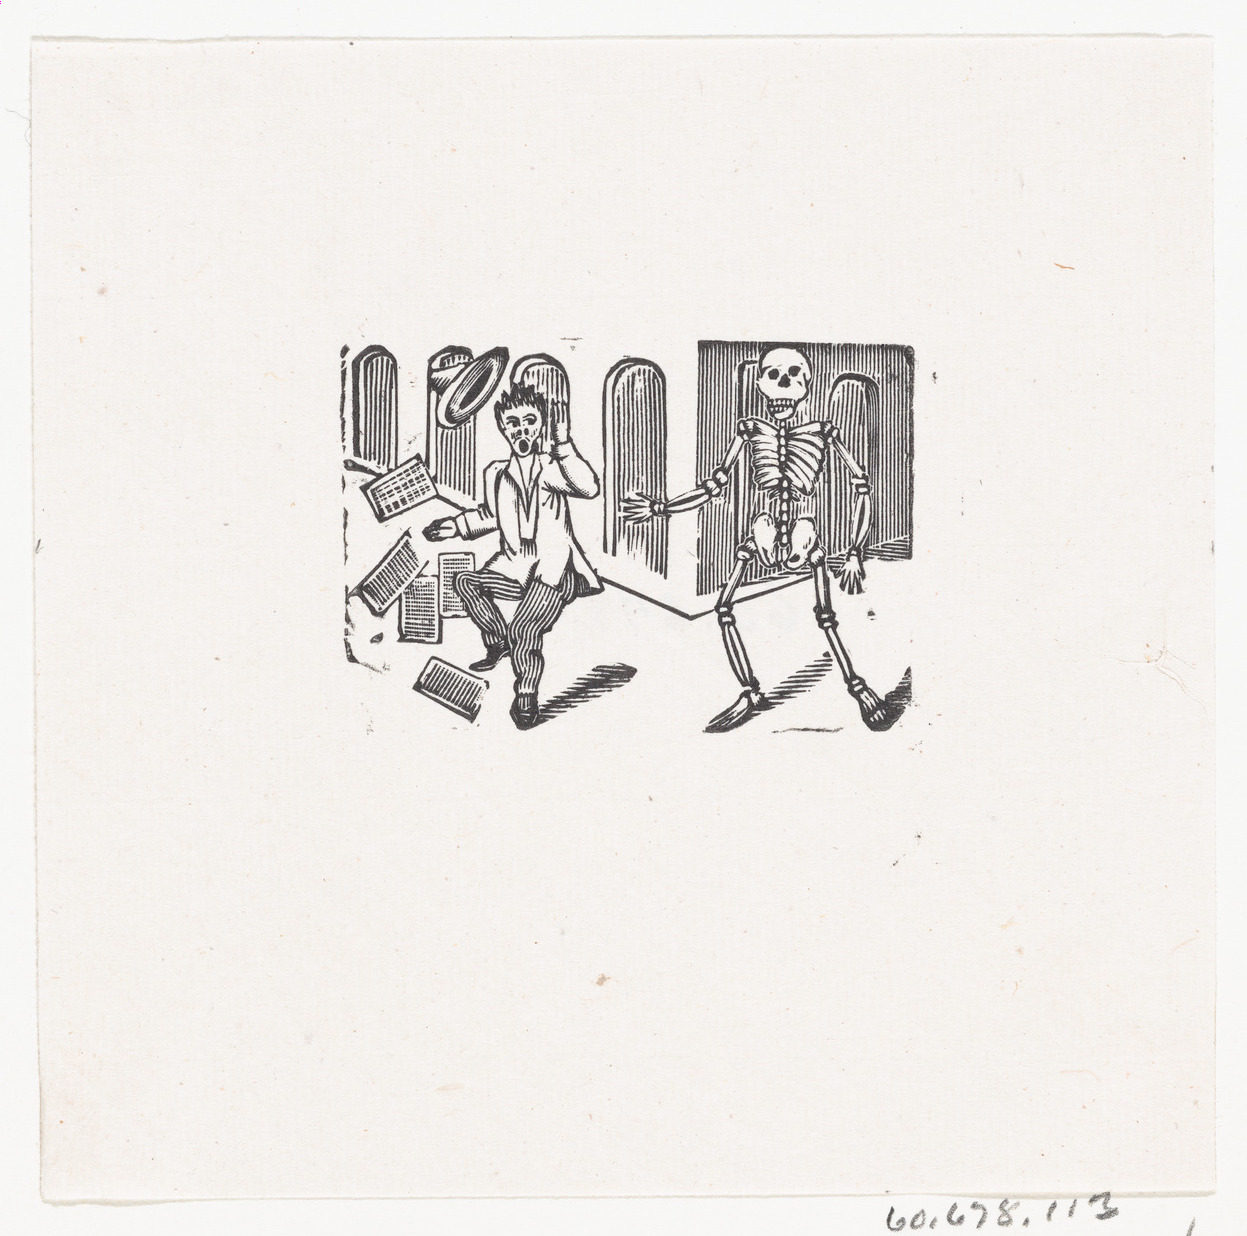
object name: print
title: A skeleton frightening a man holding newspapers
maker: josé guadalupe posada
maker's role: artist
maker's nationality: mexican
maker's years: 1852-1913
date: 1880-1910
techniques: lithography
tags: skeletons,fear,men